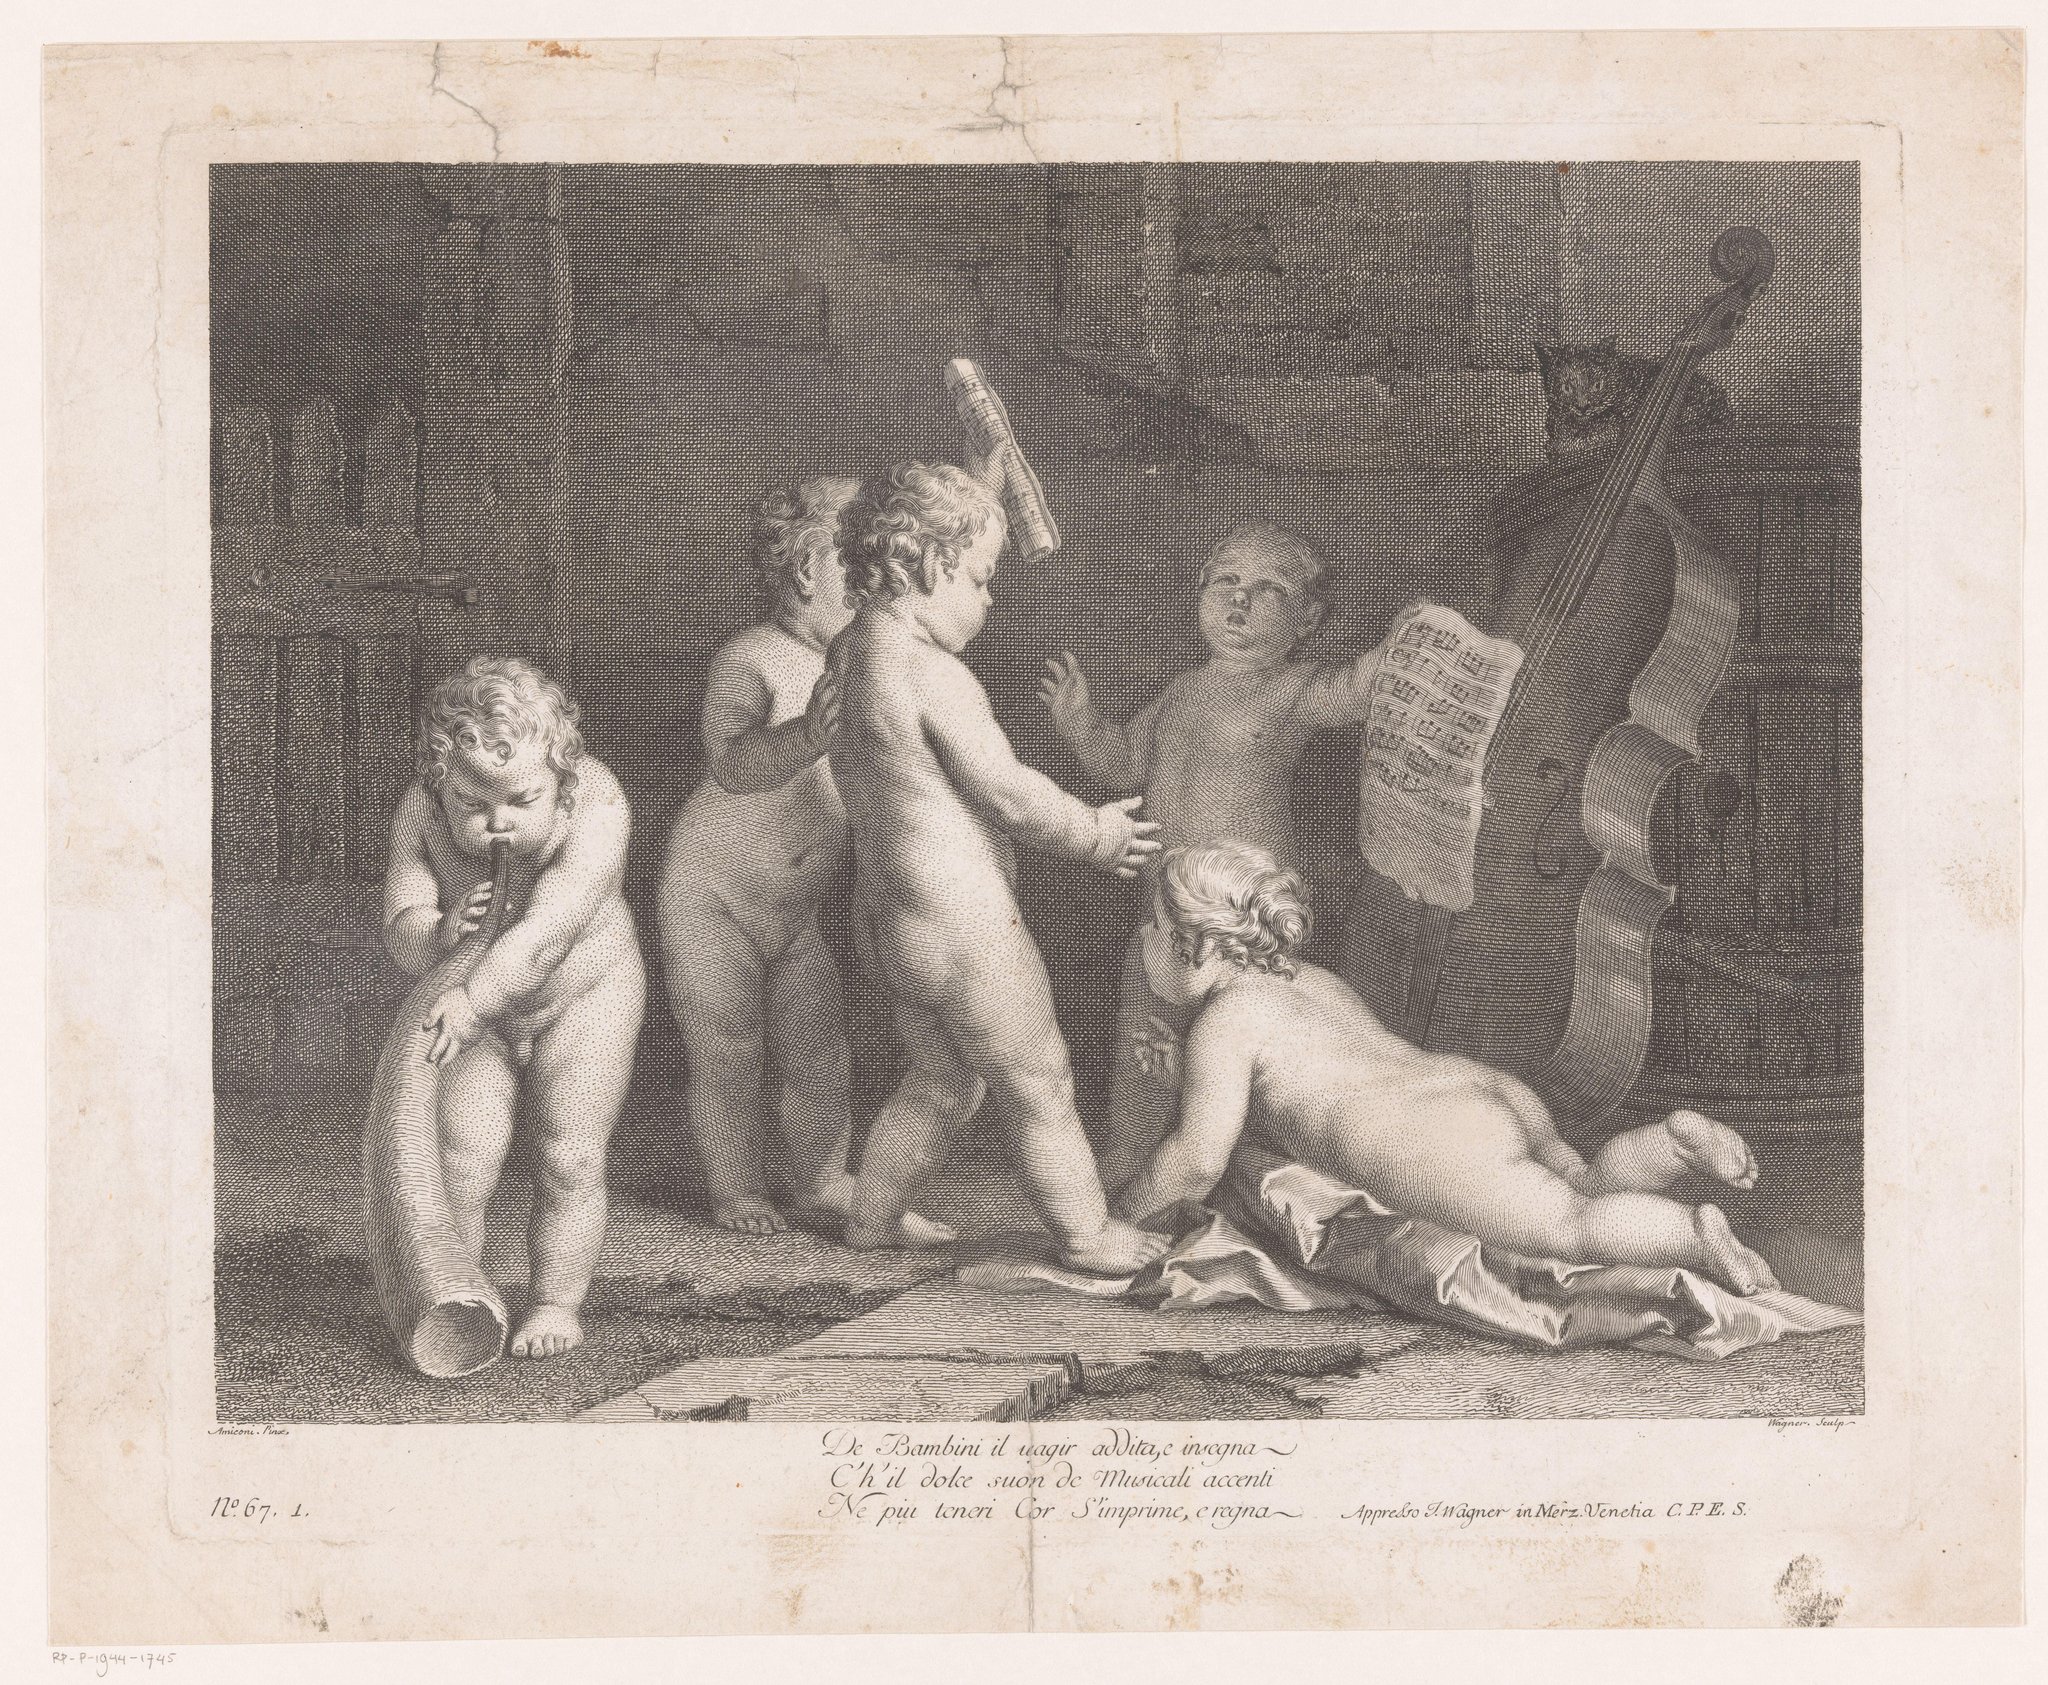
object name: print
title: Vijf musicerende kinderen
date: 1739-1780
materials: paper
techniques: etching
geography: venice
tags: notation of music, cat, viola, violoncello; double bass, wind instruments, children playing musical instruments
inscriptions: collector's mark: Lugt 2228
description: Op het verso is in potlood een van de figuren overgetrokken en voorzien van een raster.